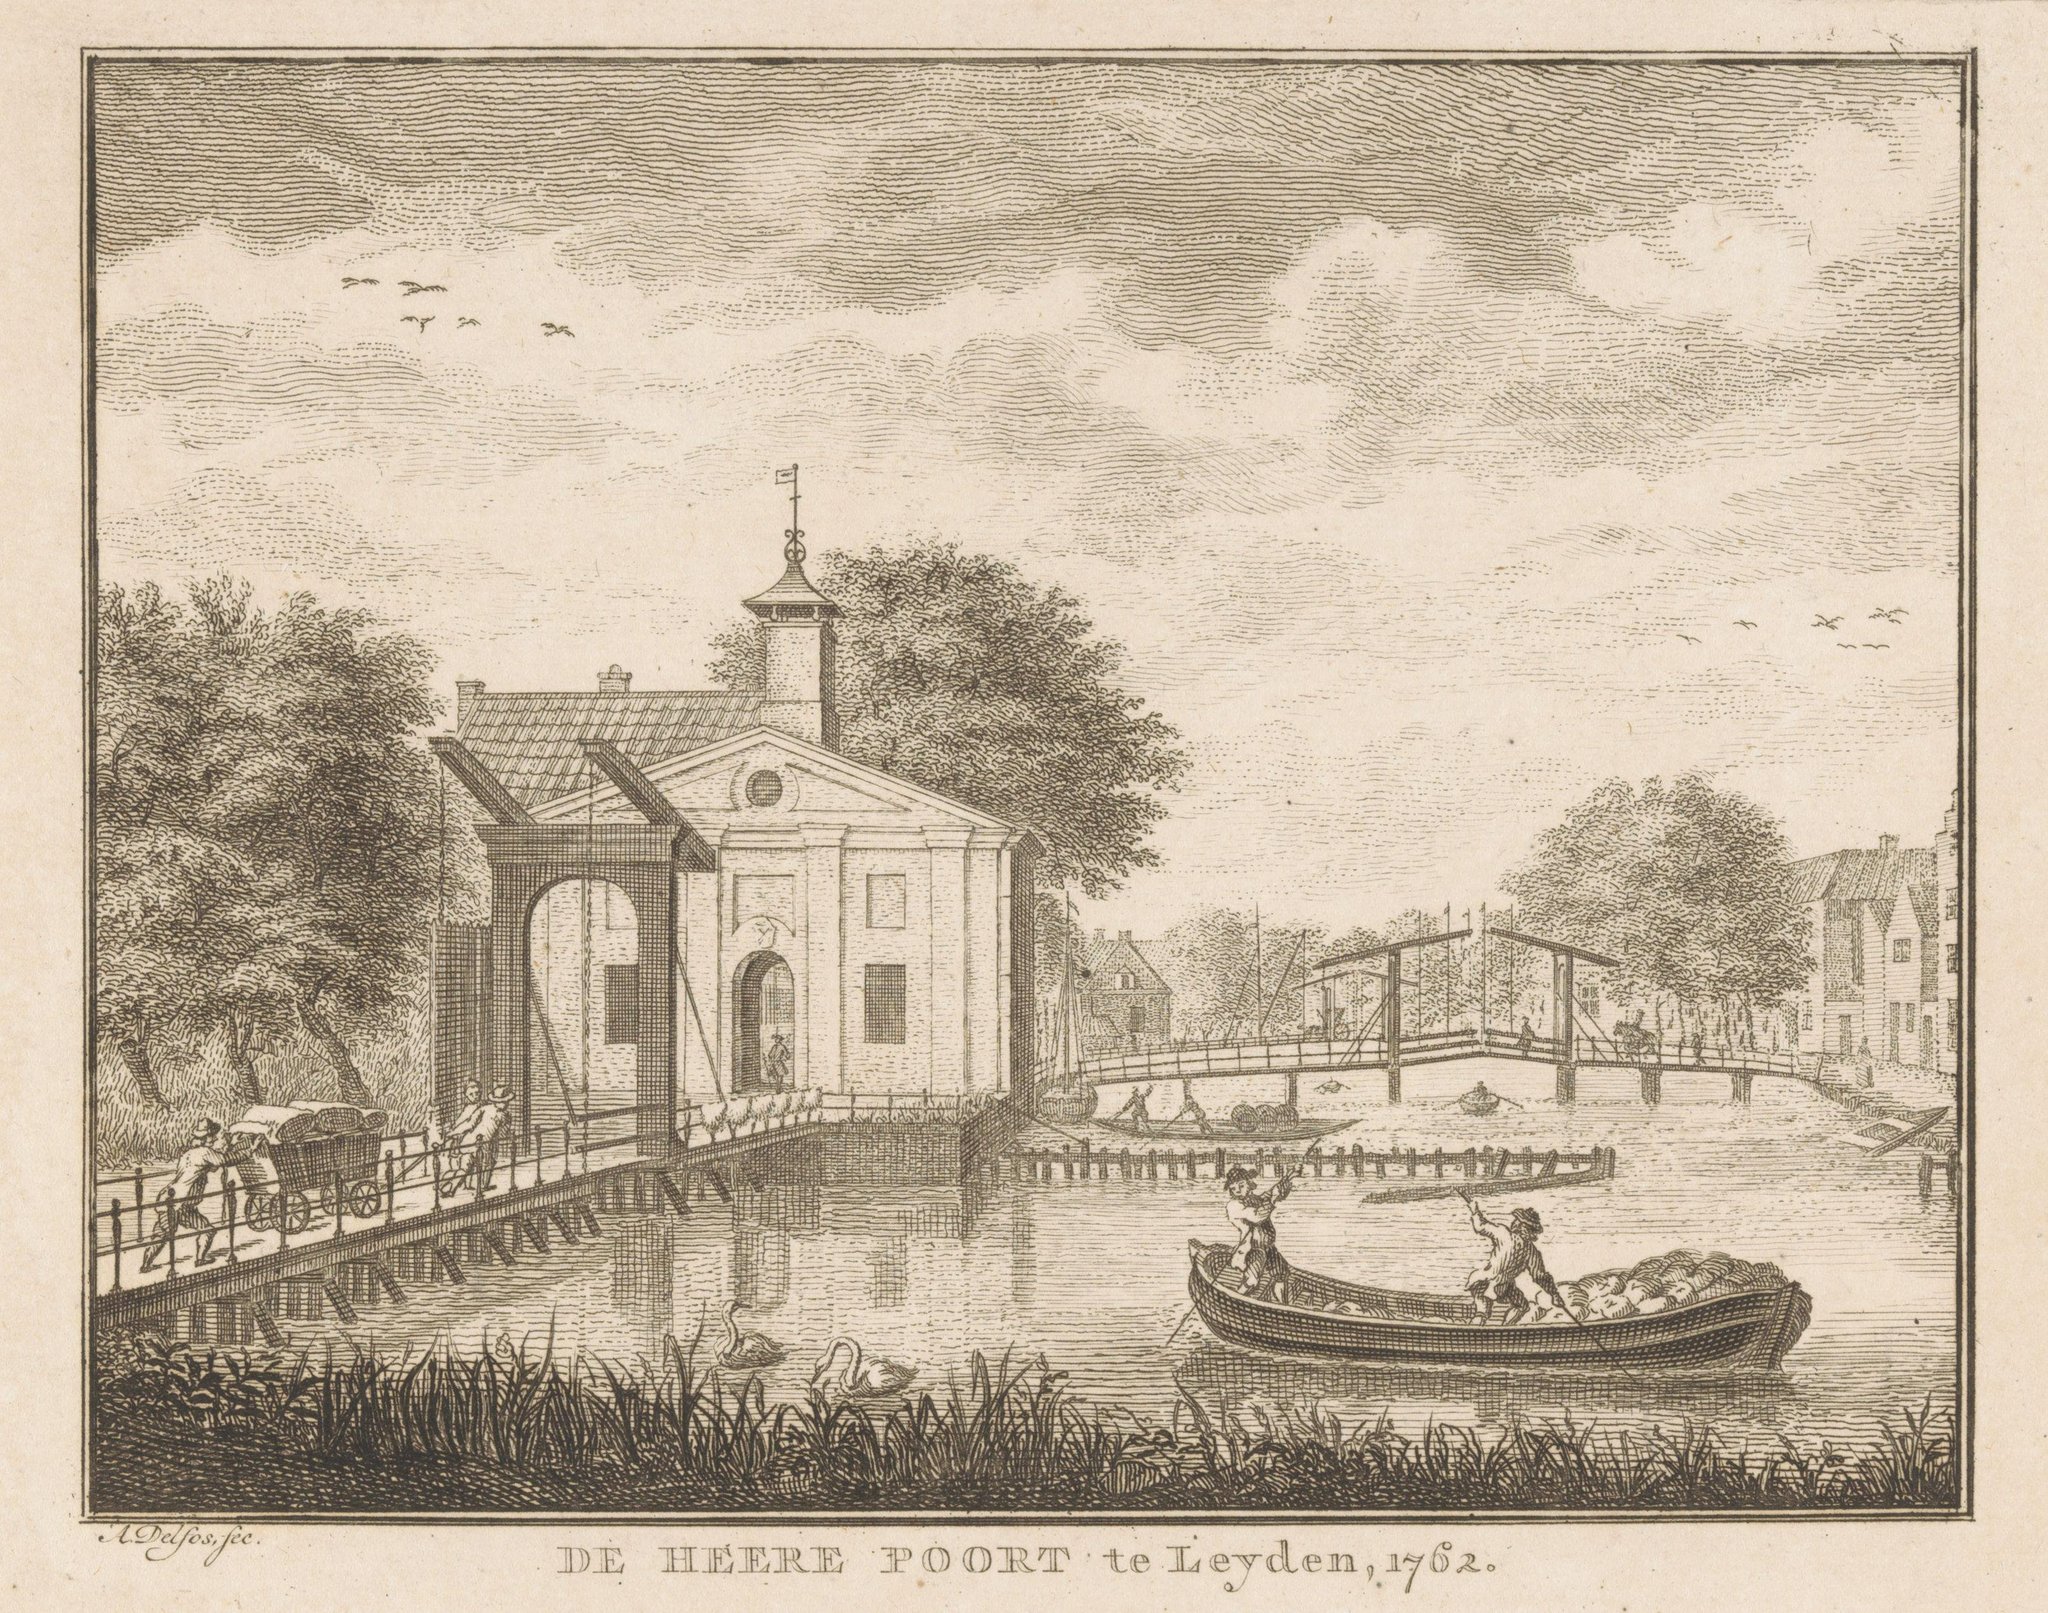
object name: print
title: De Heere Poort te Leyden, 1762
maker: abraham delfos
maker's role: draughtsman, painter, print maker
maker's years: 1731-1820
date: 1762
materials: paper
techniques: engraving, etching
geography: leiden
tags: bridge, city-gate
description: Prent ook gebruikt in: Mieris, Frans van (II). Beschryving der stad Leyden, haare gelegenheid, oorsprong, vergrootinge, oude en hedendaagsche gedaante (…). 3 delen. Leiden: weduwe Abraham Honkoop, Cornelis van Hoogeveen junior e.a., 1762-1784, dl. 1 (1762), tussen p. 20 en 21.